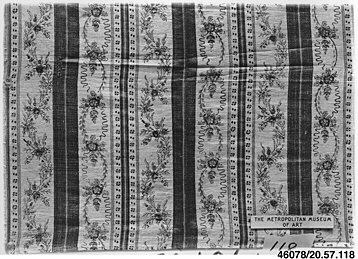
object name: piece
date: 1788-1790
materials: cotton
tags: leaves